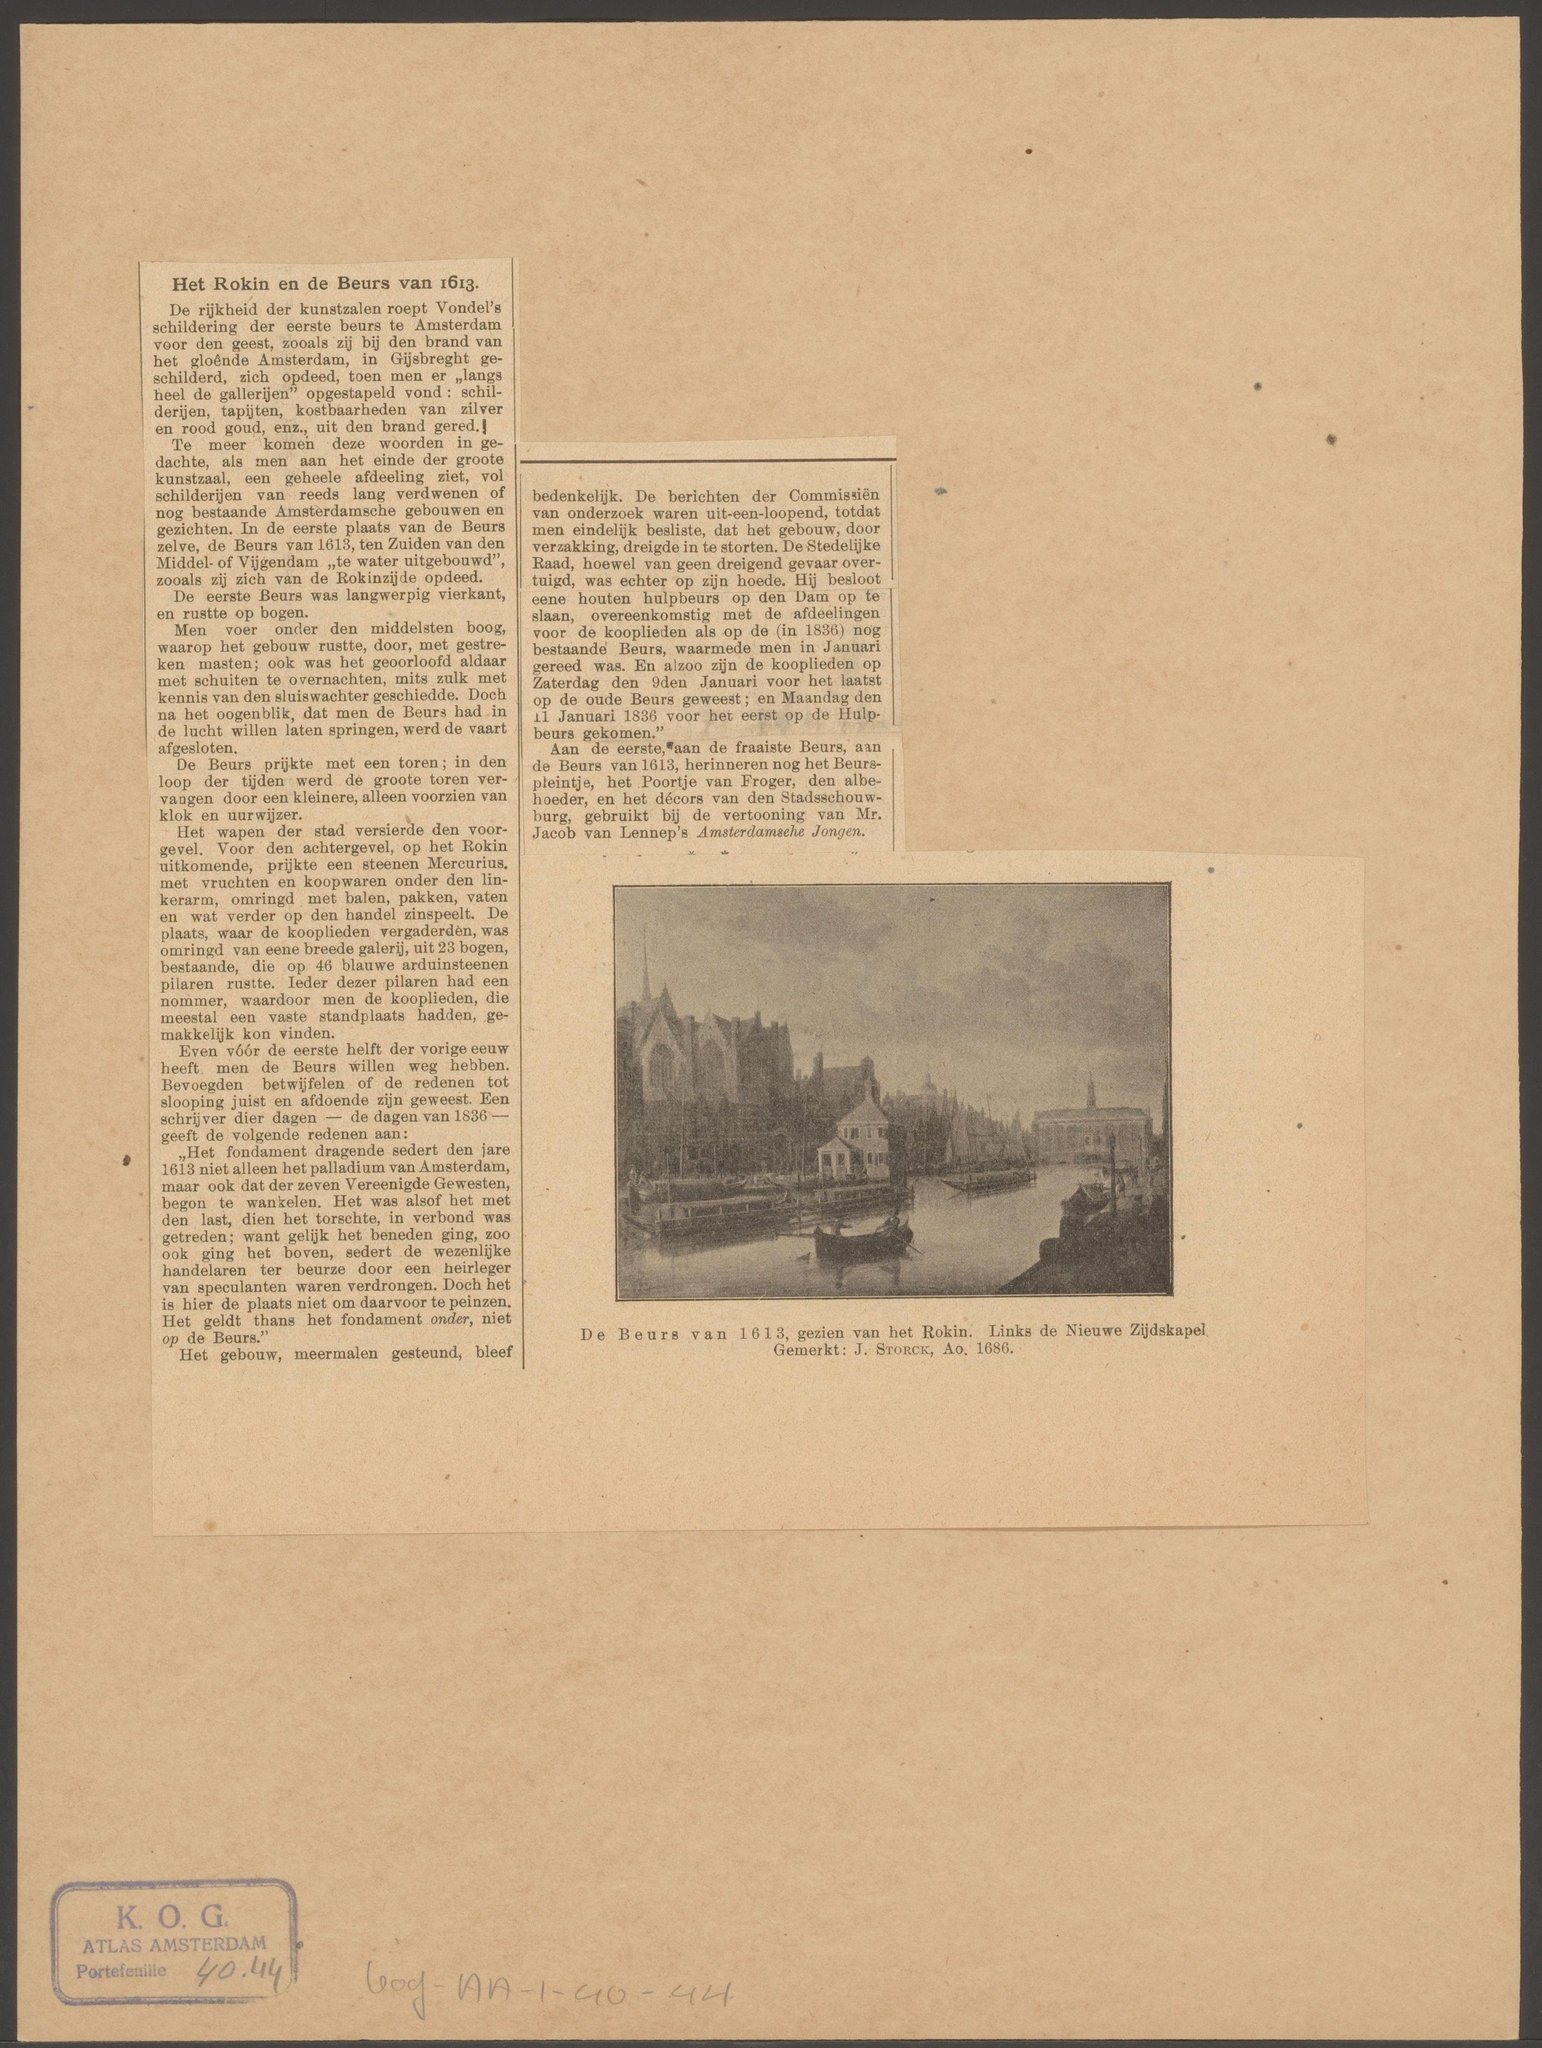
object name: photomechanical print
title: Gezicht op het Rokin, de Beurs van Hendrik de Keyser en de Nieuwezijds Kapel te Amsterdam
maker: Anonymous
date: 1906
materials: paper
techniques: letterpress printing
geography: amsterdam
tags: stock exchange, stock-market, ships (in general), church (exterior) - qq - small church, chapel, canals, waters (in city) (+ city(-scape) with figures, staffage)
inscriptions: collector's mark: Lugt 1641b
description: Object bestaat uit vier aan elkaar geplakte bladen. Onderwerpsrubriek binnen de Atlas Amsterdam: Handel en Zeevaart: Beurs op het Rokin.